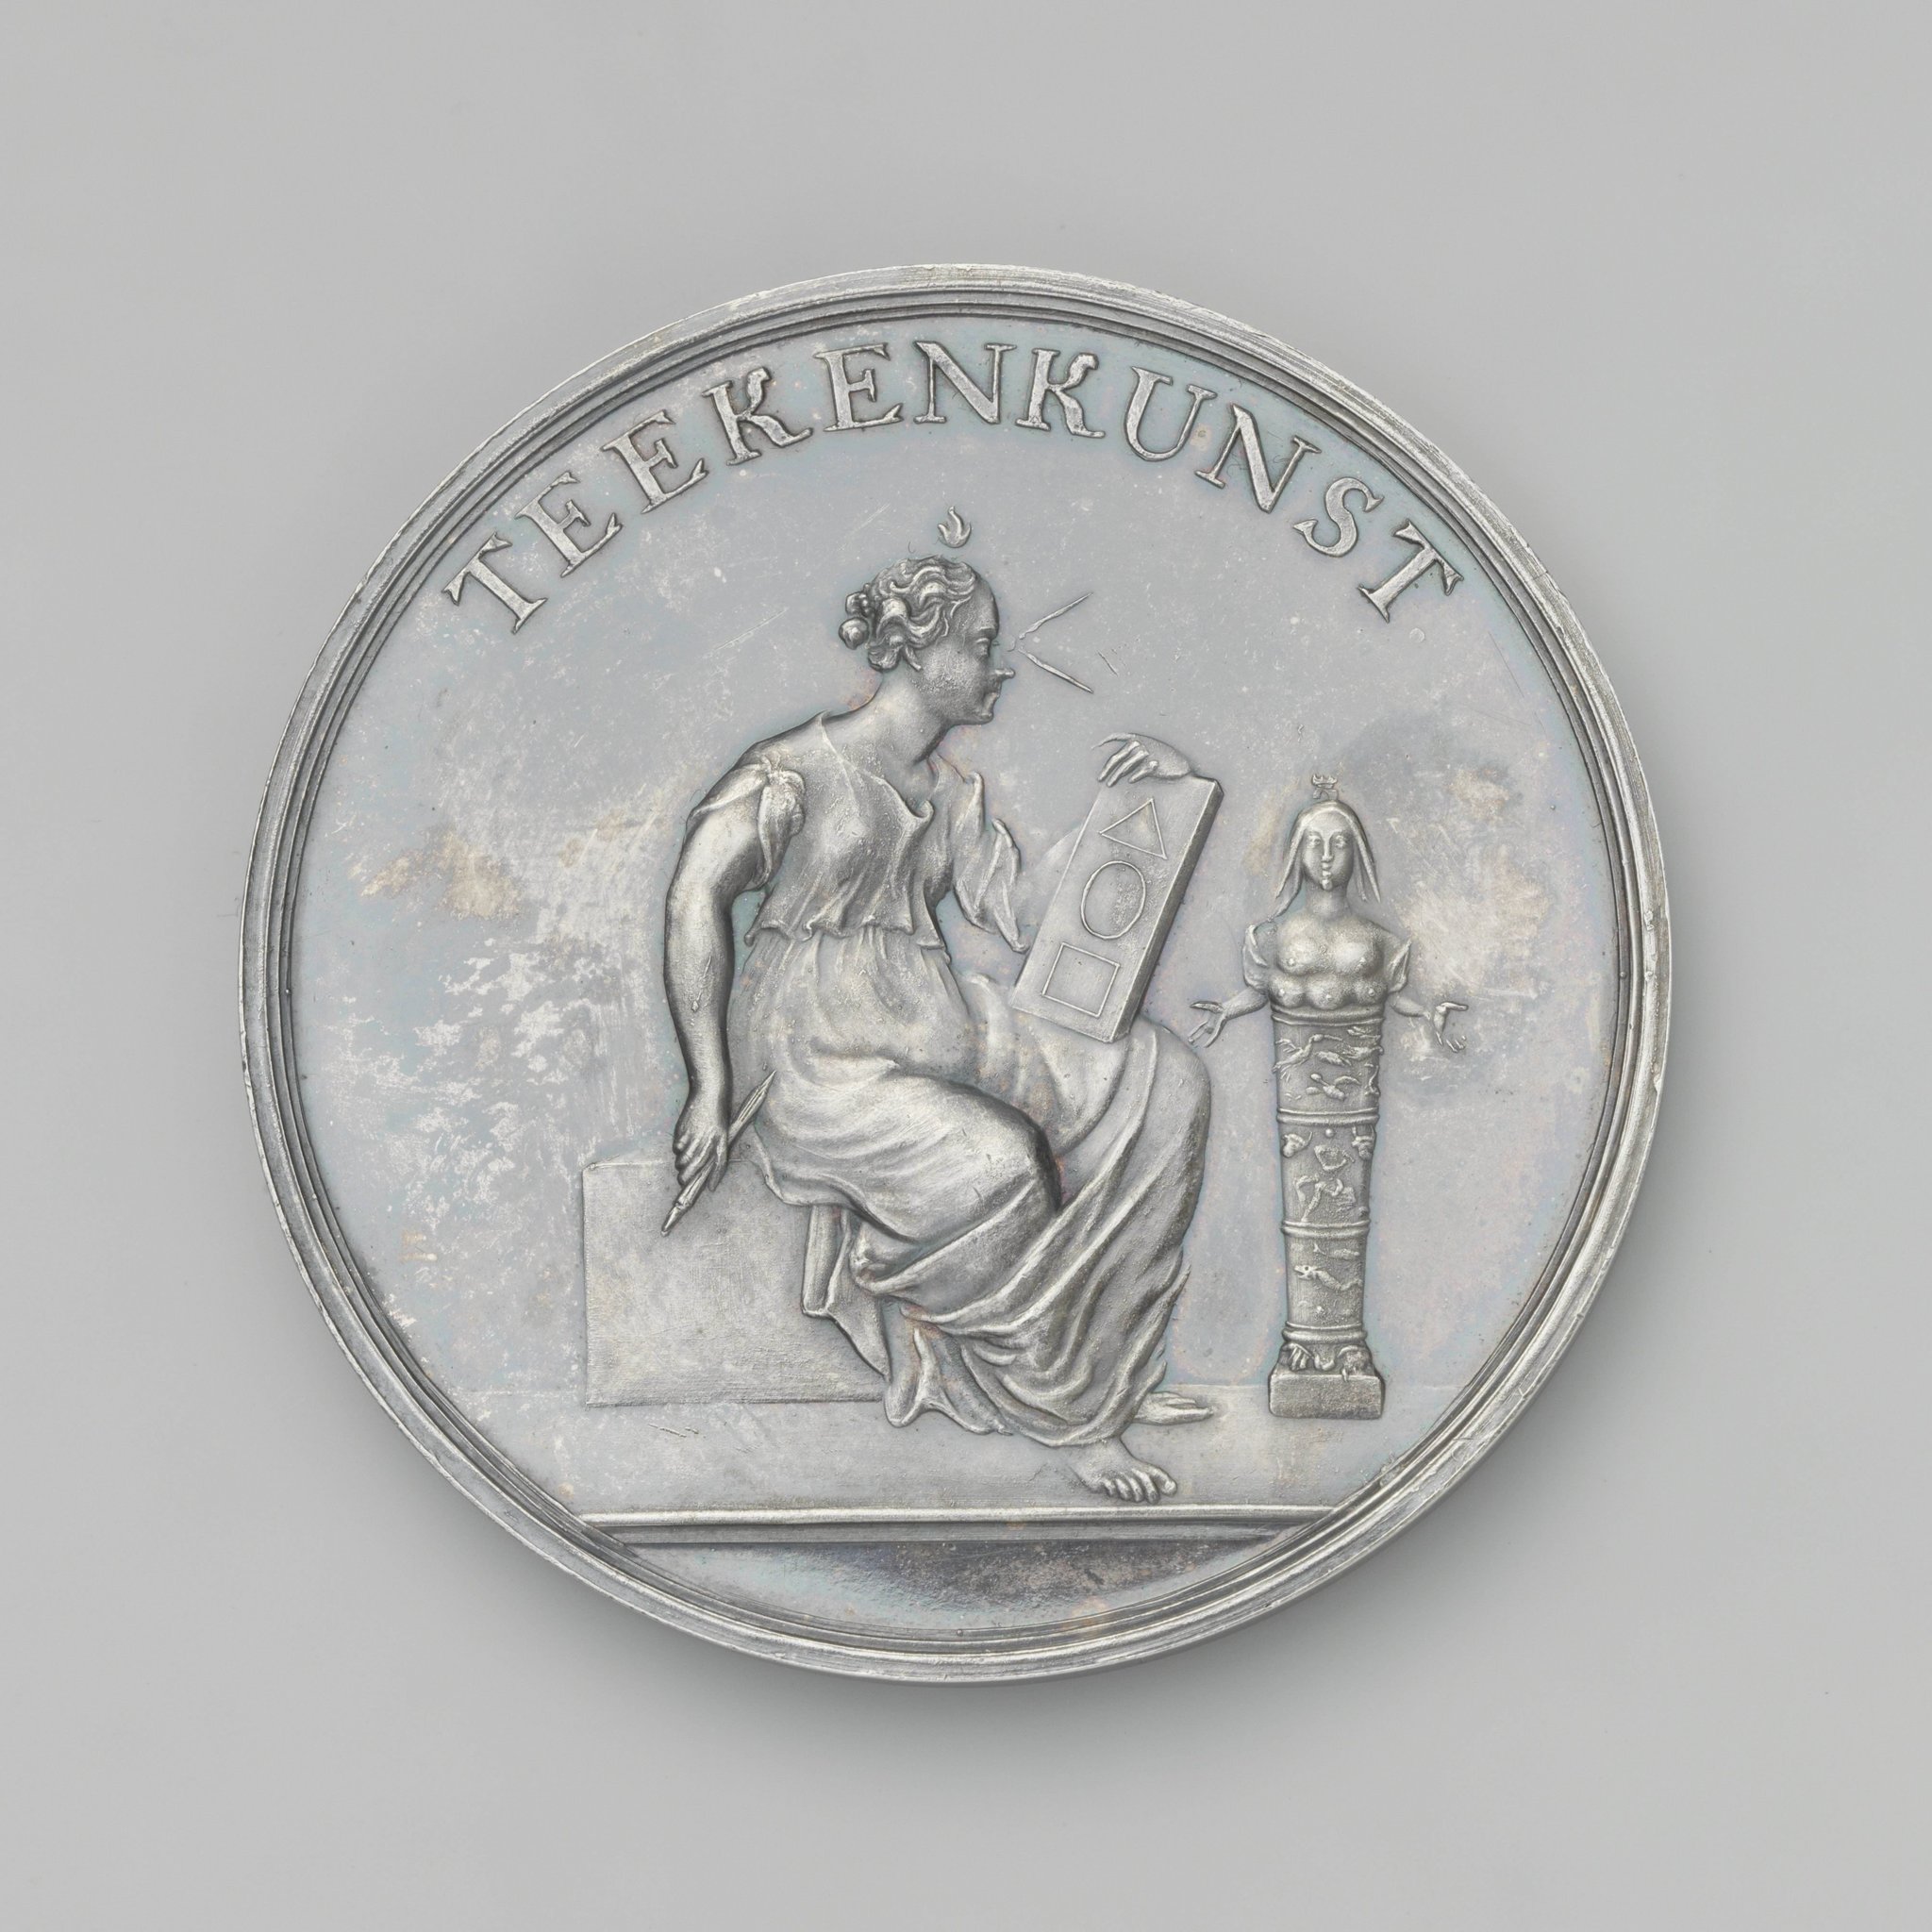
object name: medal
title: Amsterdam Drawing Academy medal to Abraham van der Hart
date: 1765-1802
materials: silver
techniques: engraving, striking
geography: amsterdam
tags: amsterdam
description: Medals of honour. Medals of honour were awarded to individuals for noteworthy achievements.